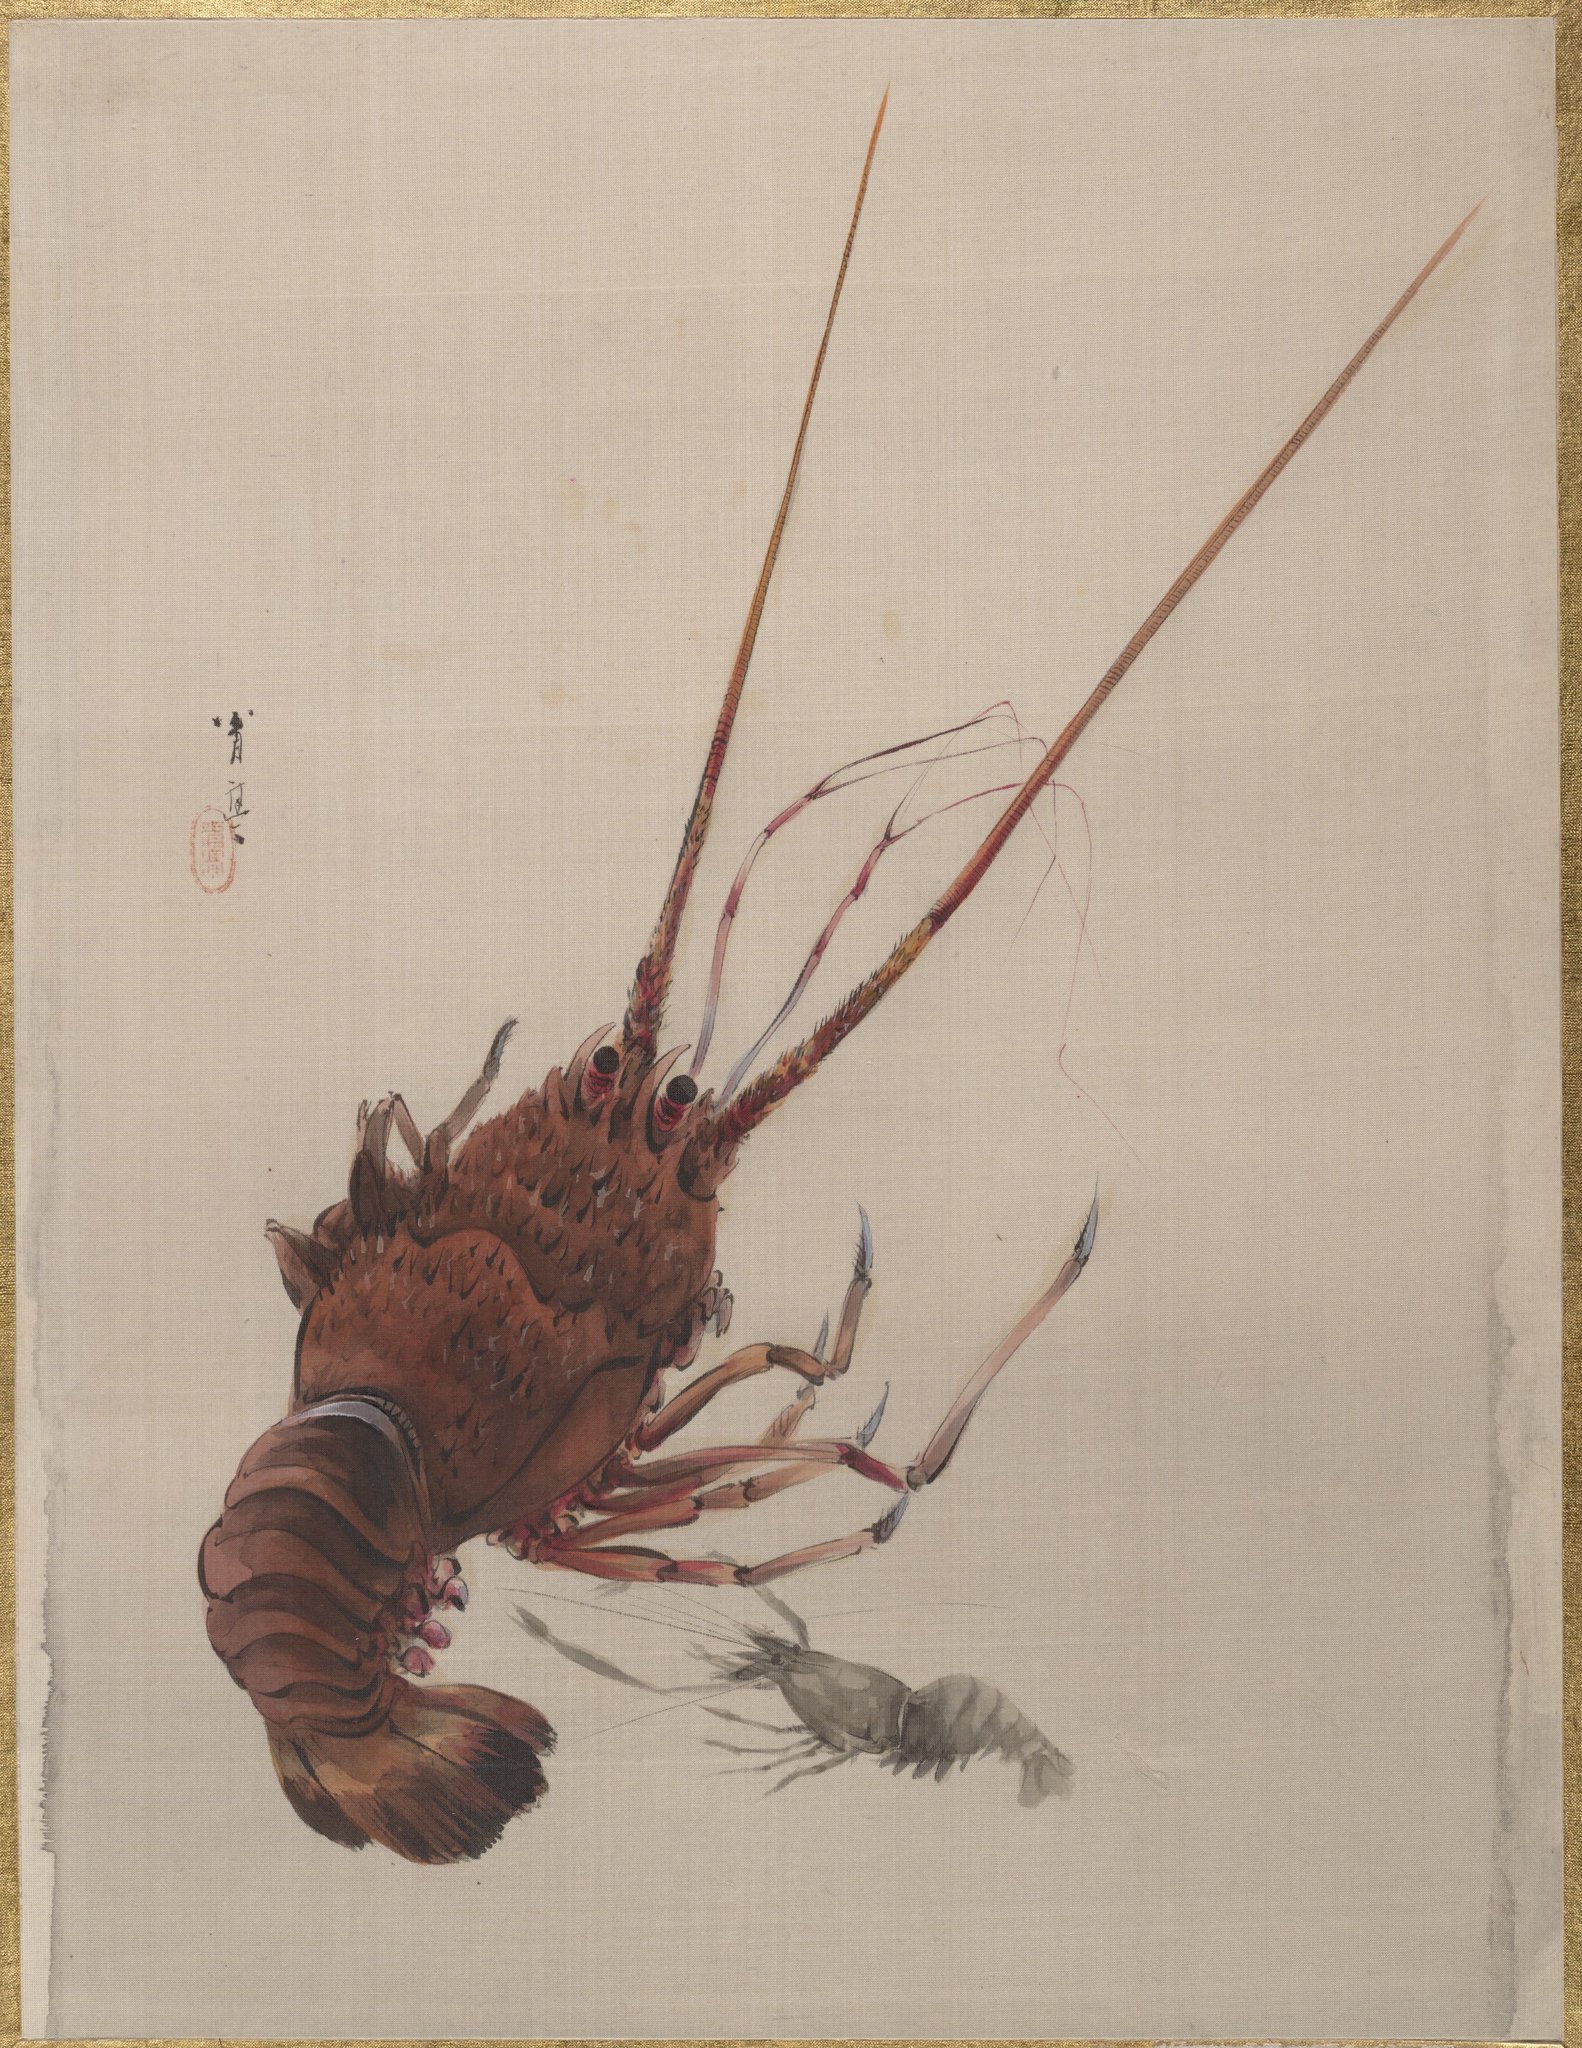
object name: album leaf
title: Crayfish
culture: japanese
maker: watanabe seitei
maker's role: artist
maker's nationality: japanese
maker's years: 1851-1918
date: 1887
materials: ink, silk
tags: crayfish